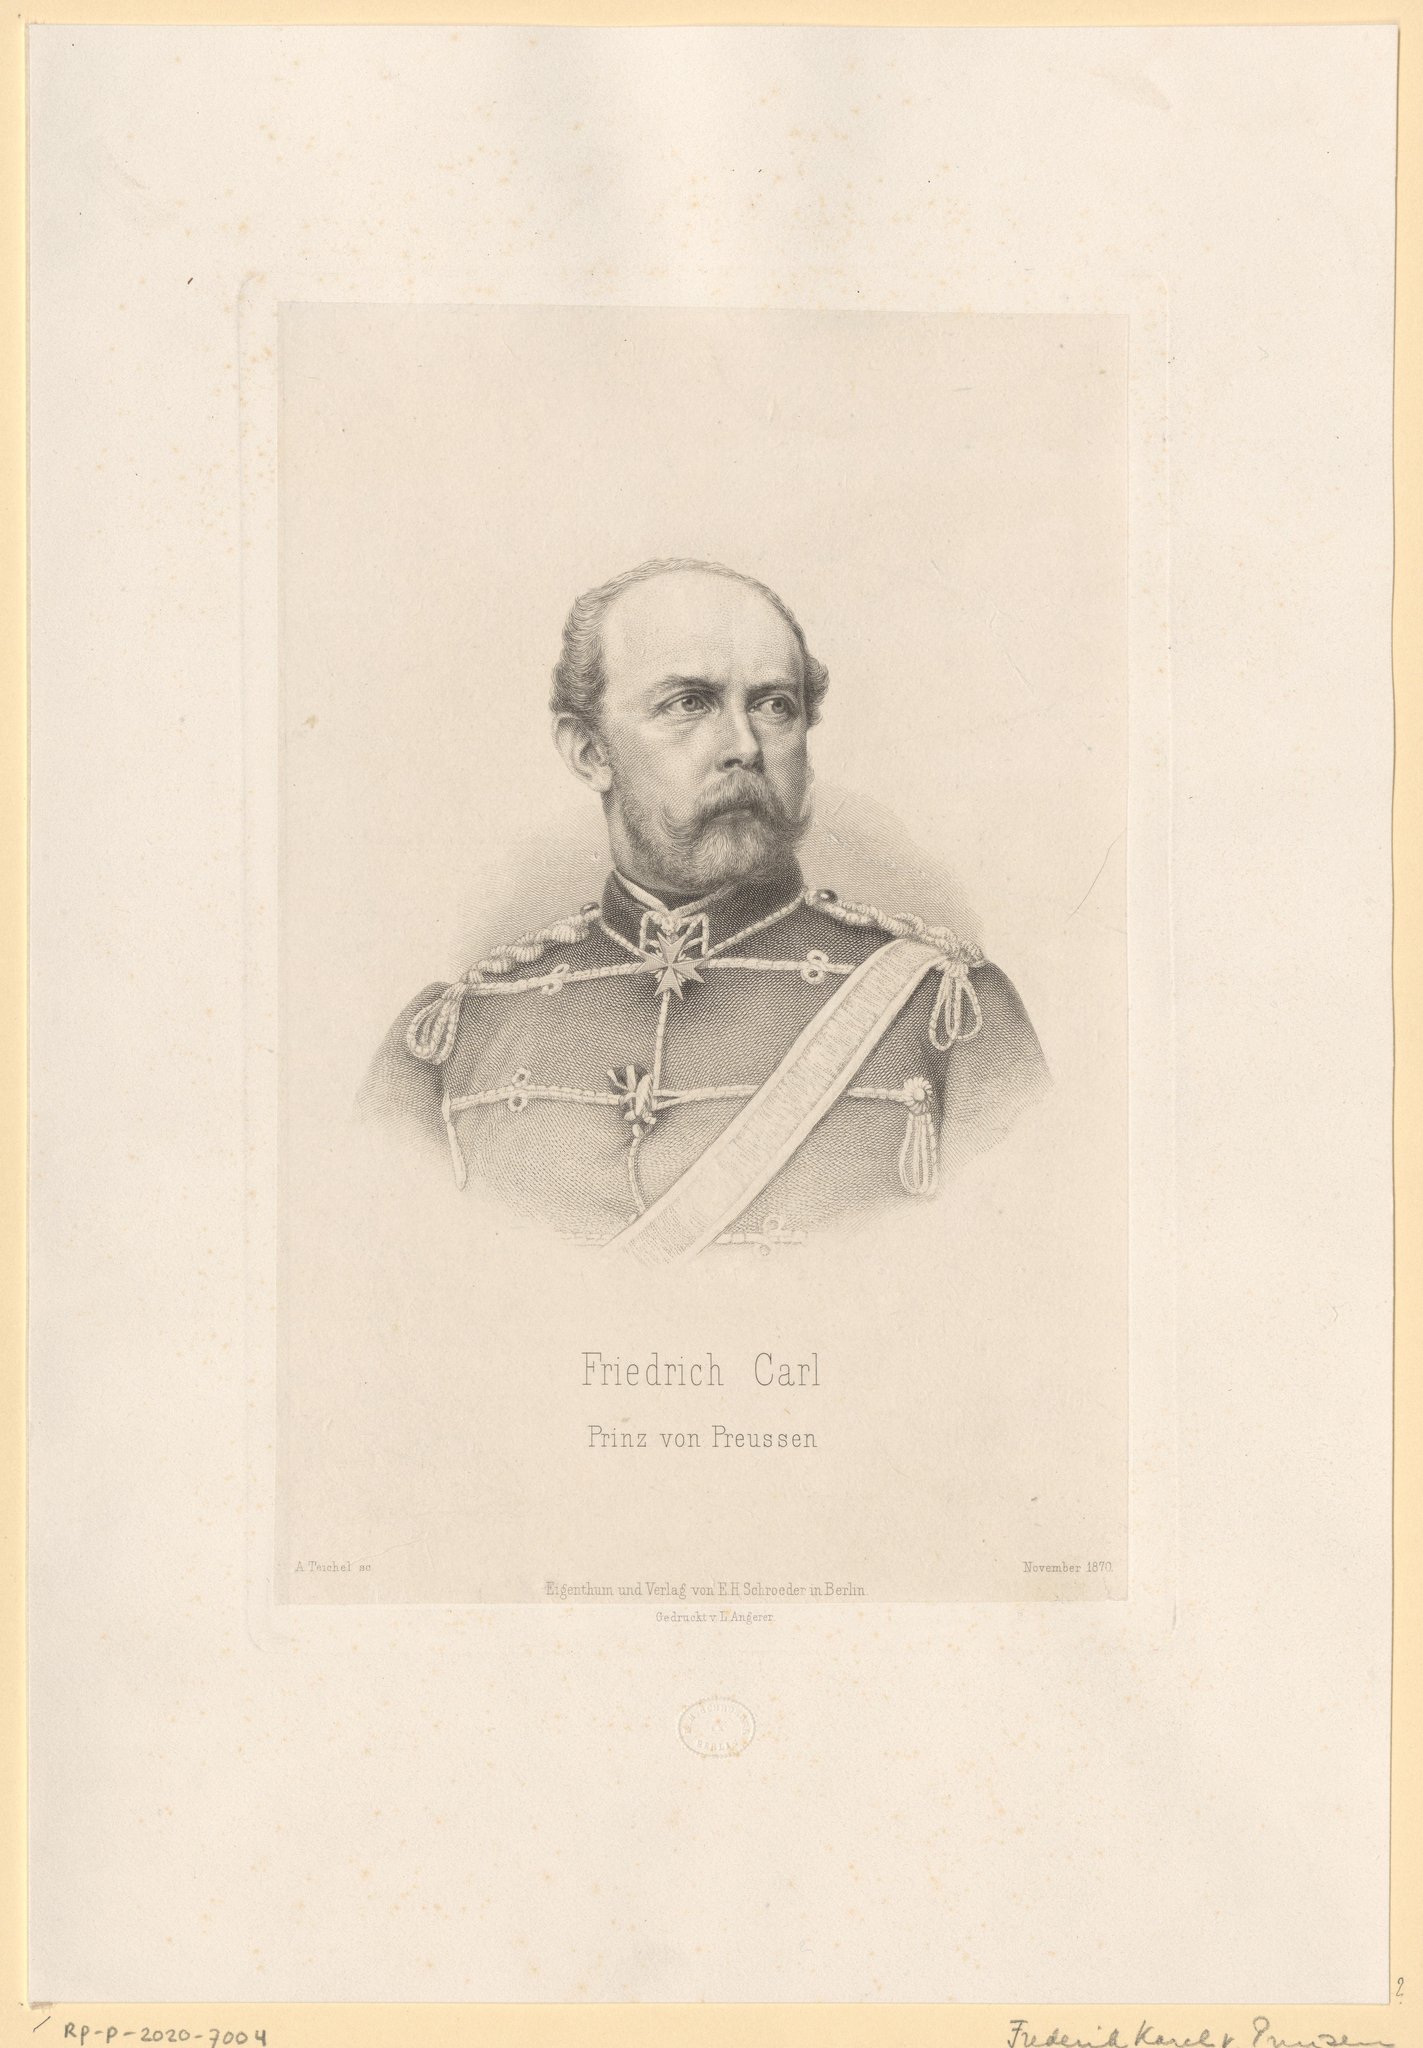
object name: print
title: Portret van Frederik Karel van Pruisen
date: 1811-1870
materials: paper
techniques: etching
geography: berlin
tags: berlin, prince, historical persons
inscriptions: check stamp: Lugt 5326